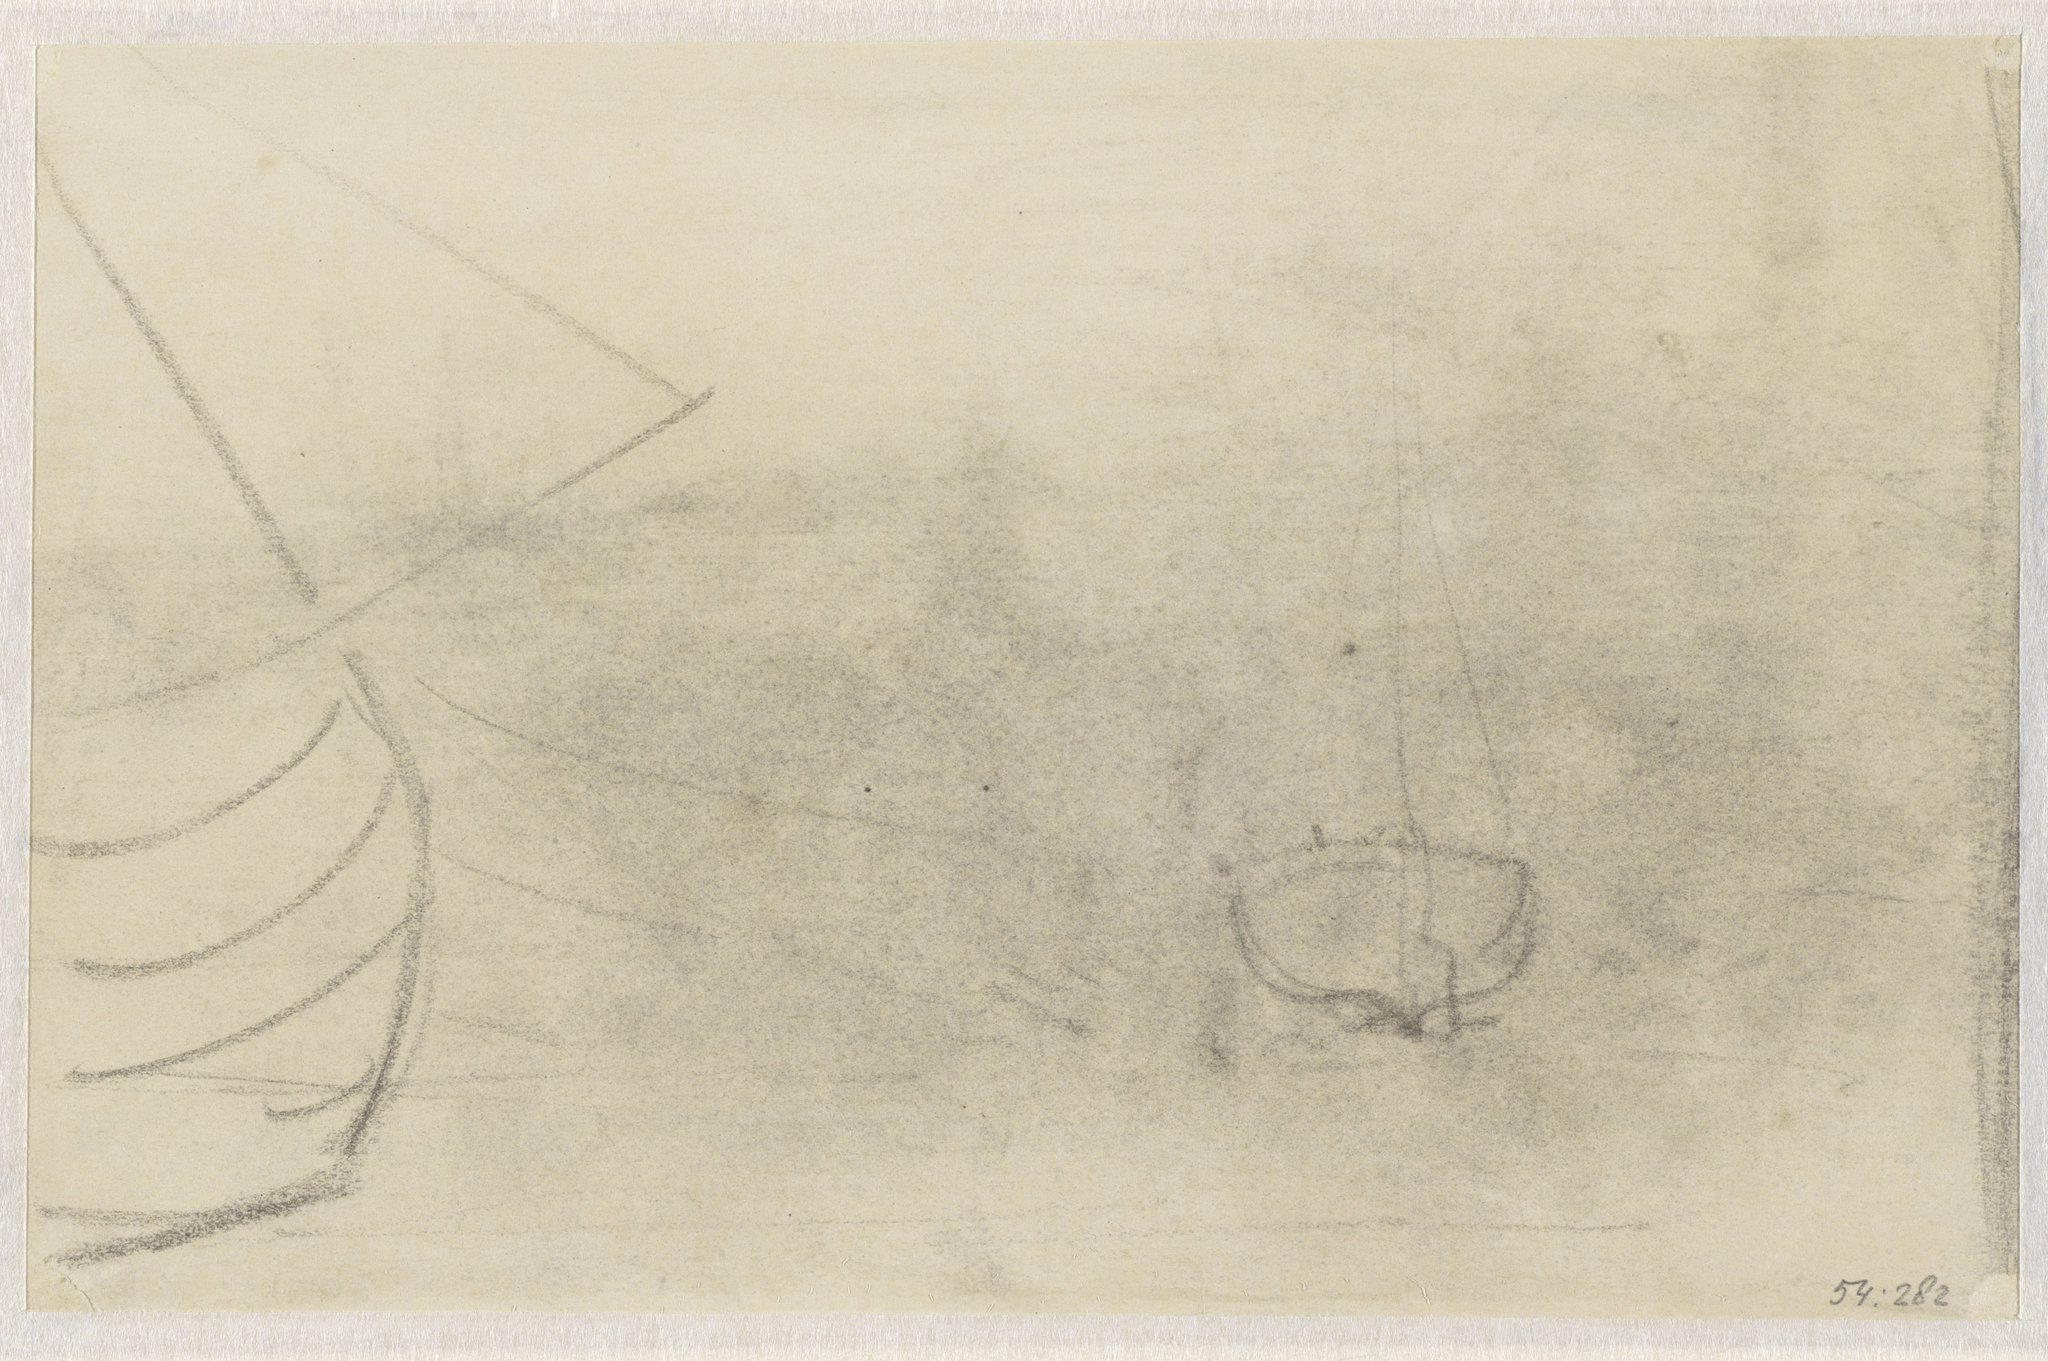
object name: drawing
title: Enkele schuiten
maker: anton mauve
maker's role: draughtsman, painter, print maker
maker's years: 1838-1888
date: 1848-1888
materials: chalk, paper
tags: sailing-ship, sailing-boat